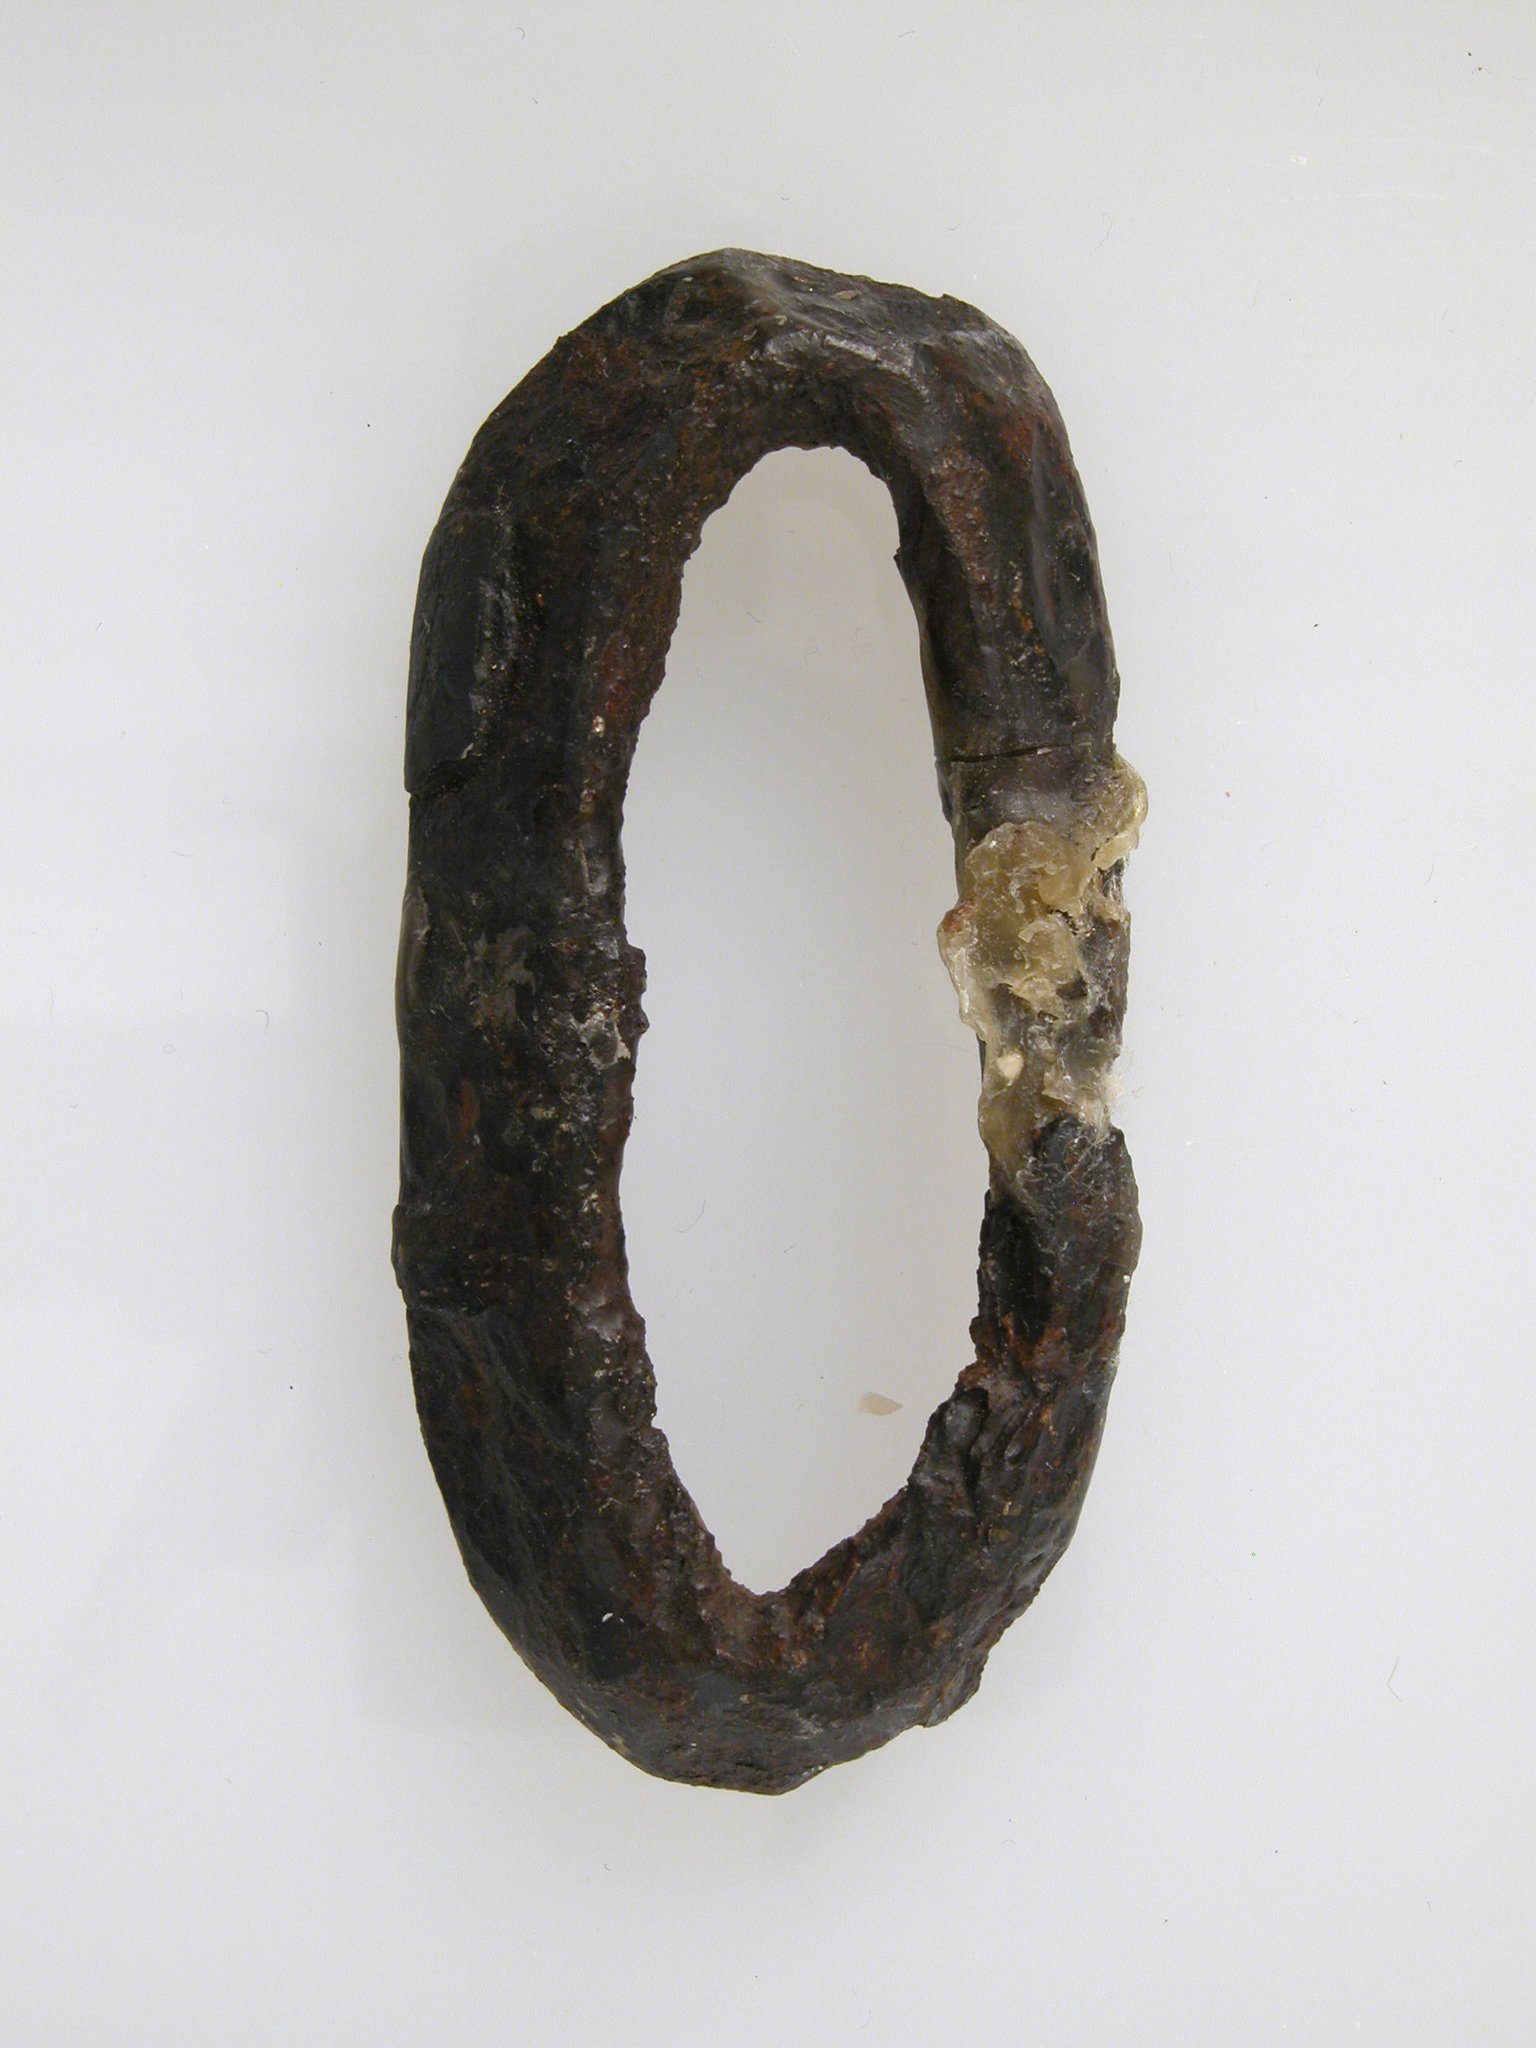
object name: buckle loop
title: Belt Buckle Loop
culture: burgundian or frankish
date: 301-700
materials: iron, silver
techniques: inlay